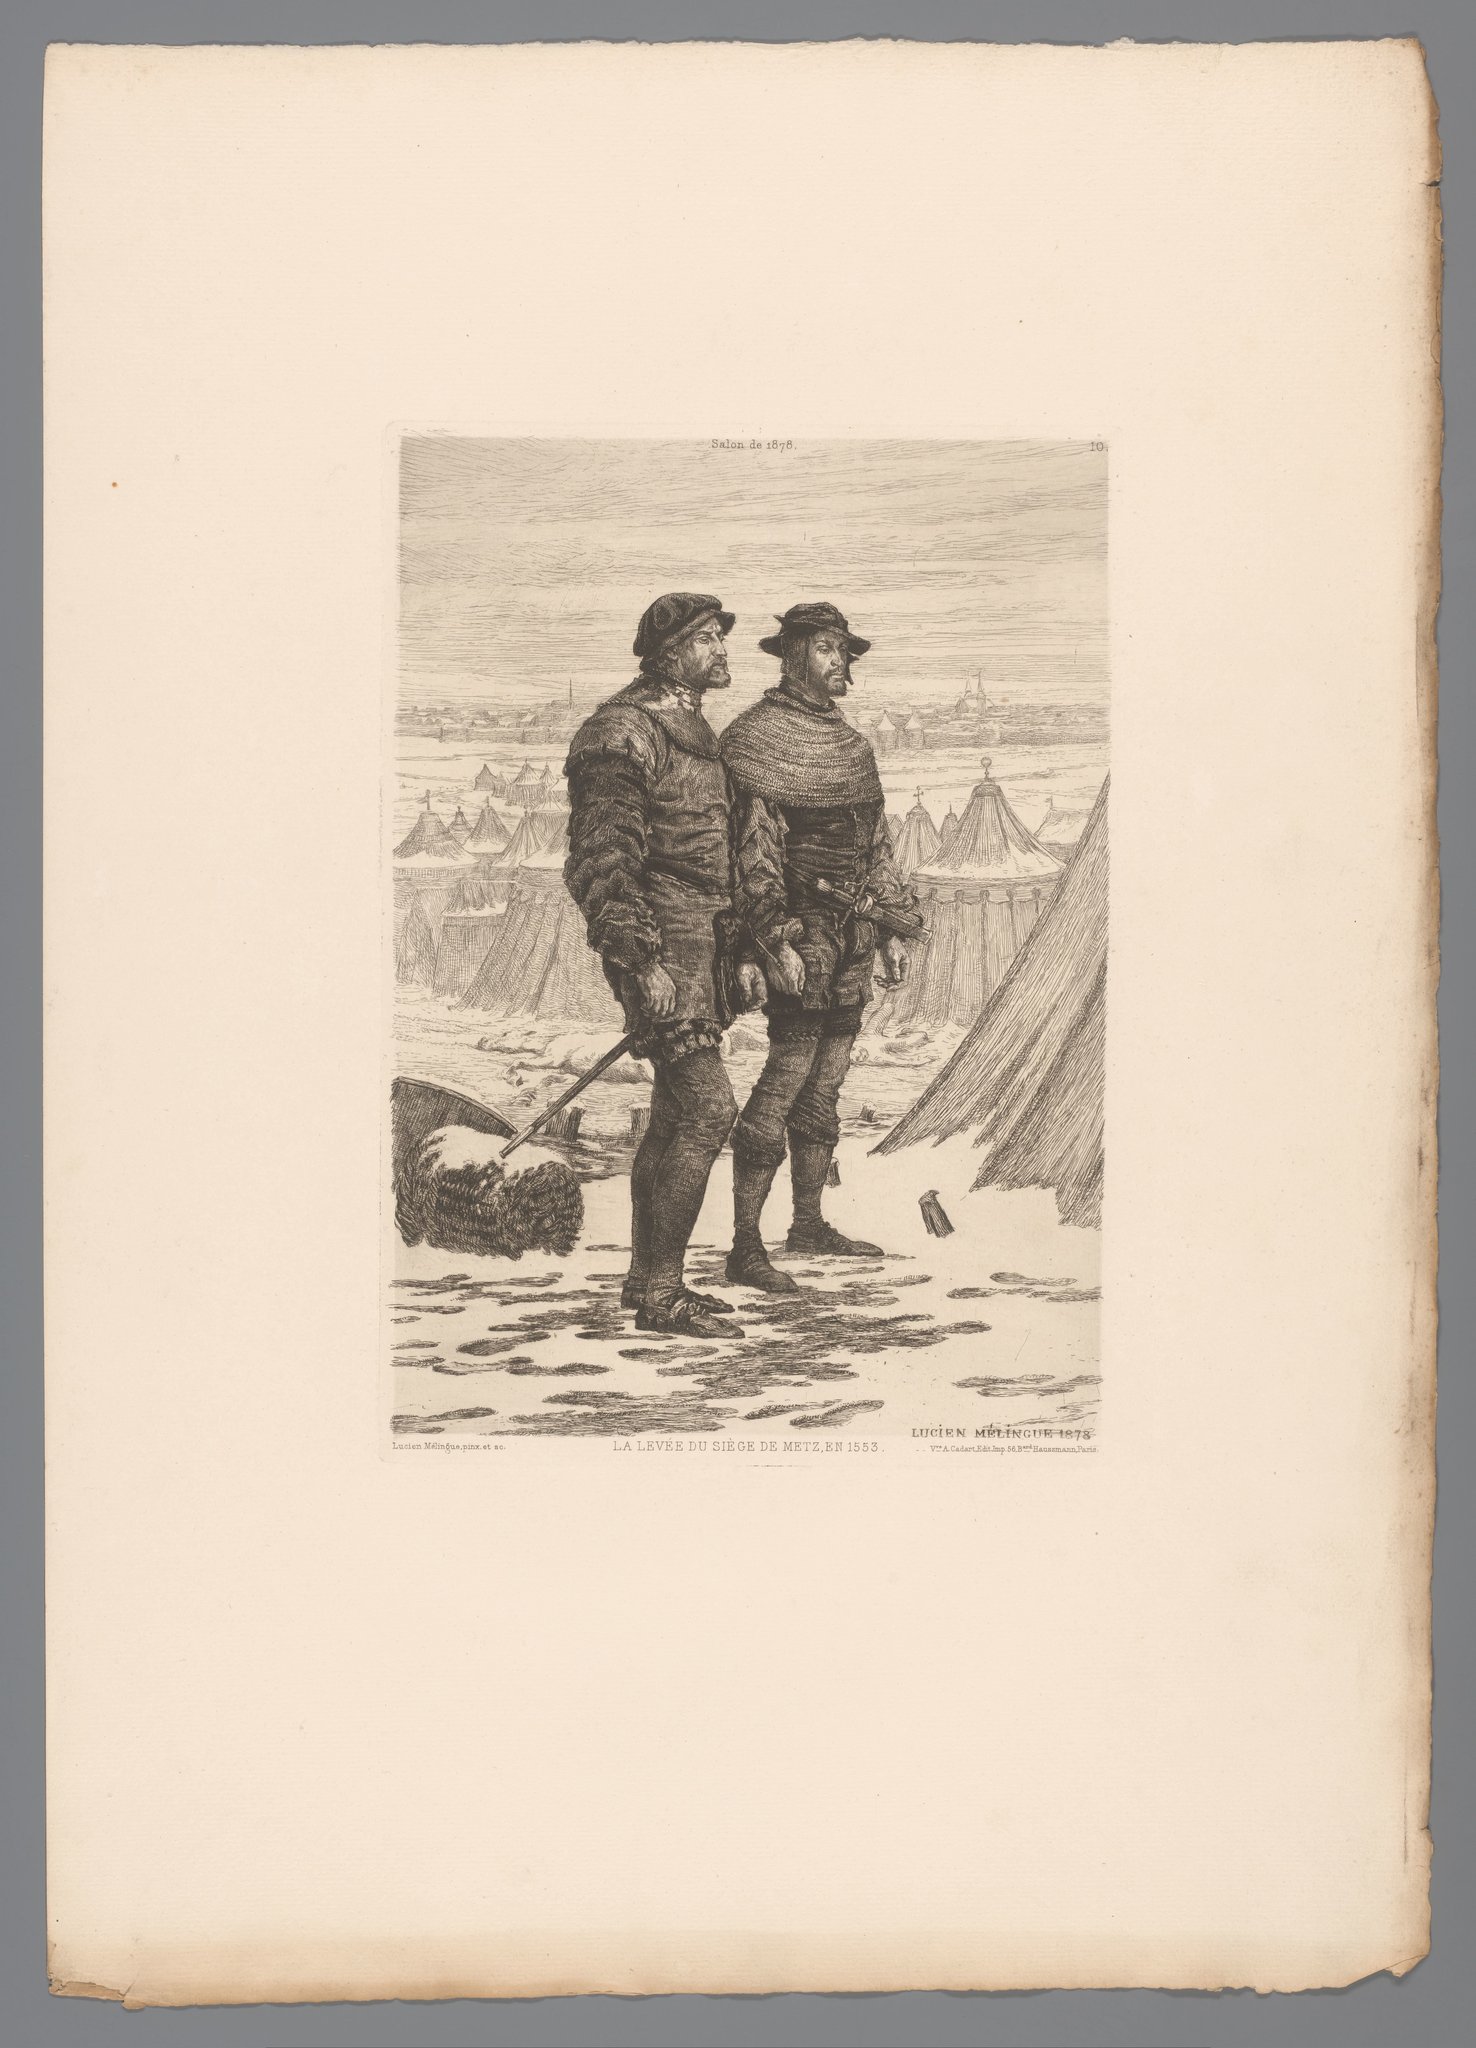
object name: print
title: L'eau-forte en 1879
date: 1879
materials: paper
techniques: drypoint, etching, intaglio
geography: paris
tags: (military) camp with tents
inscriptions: collector's mark: Lugt 2228, collector's mark: Lugt 2760, watermark, collector's mark: ‘AFE v S’